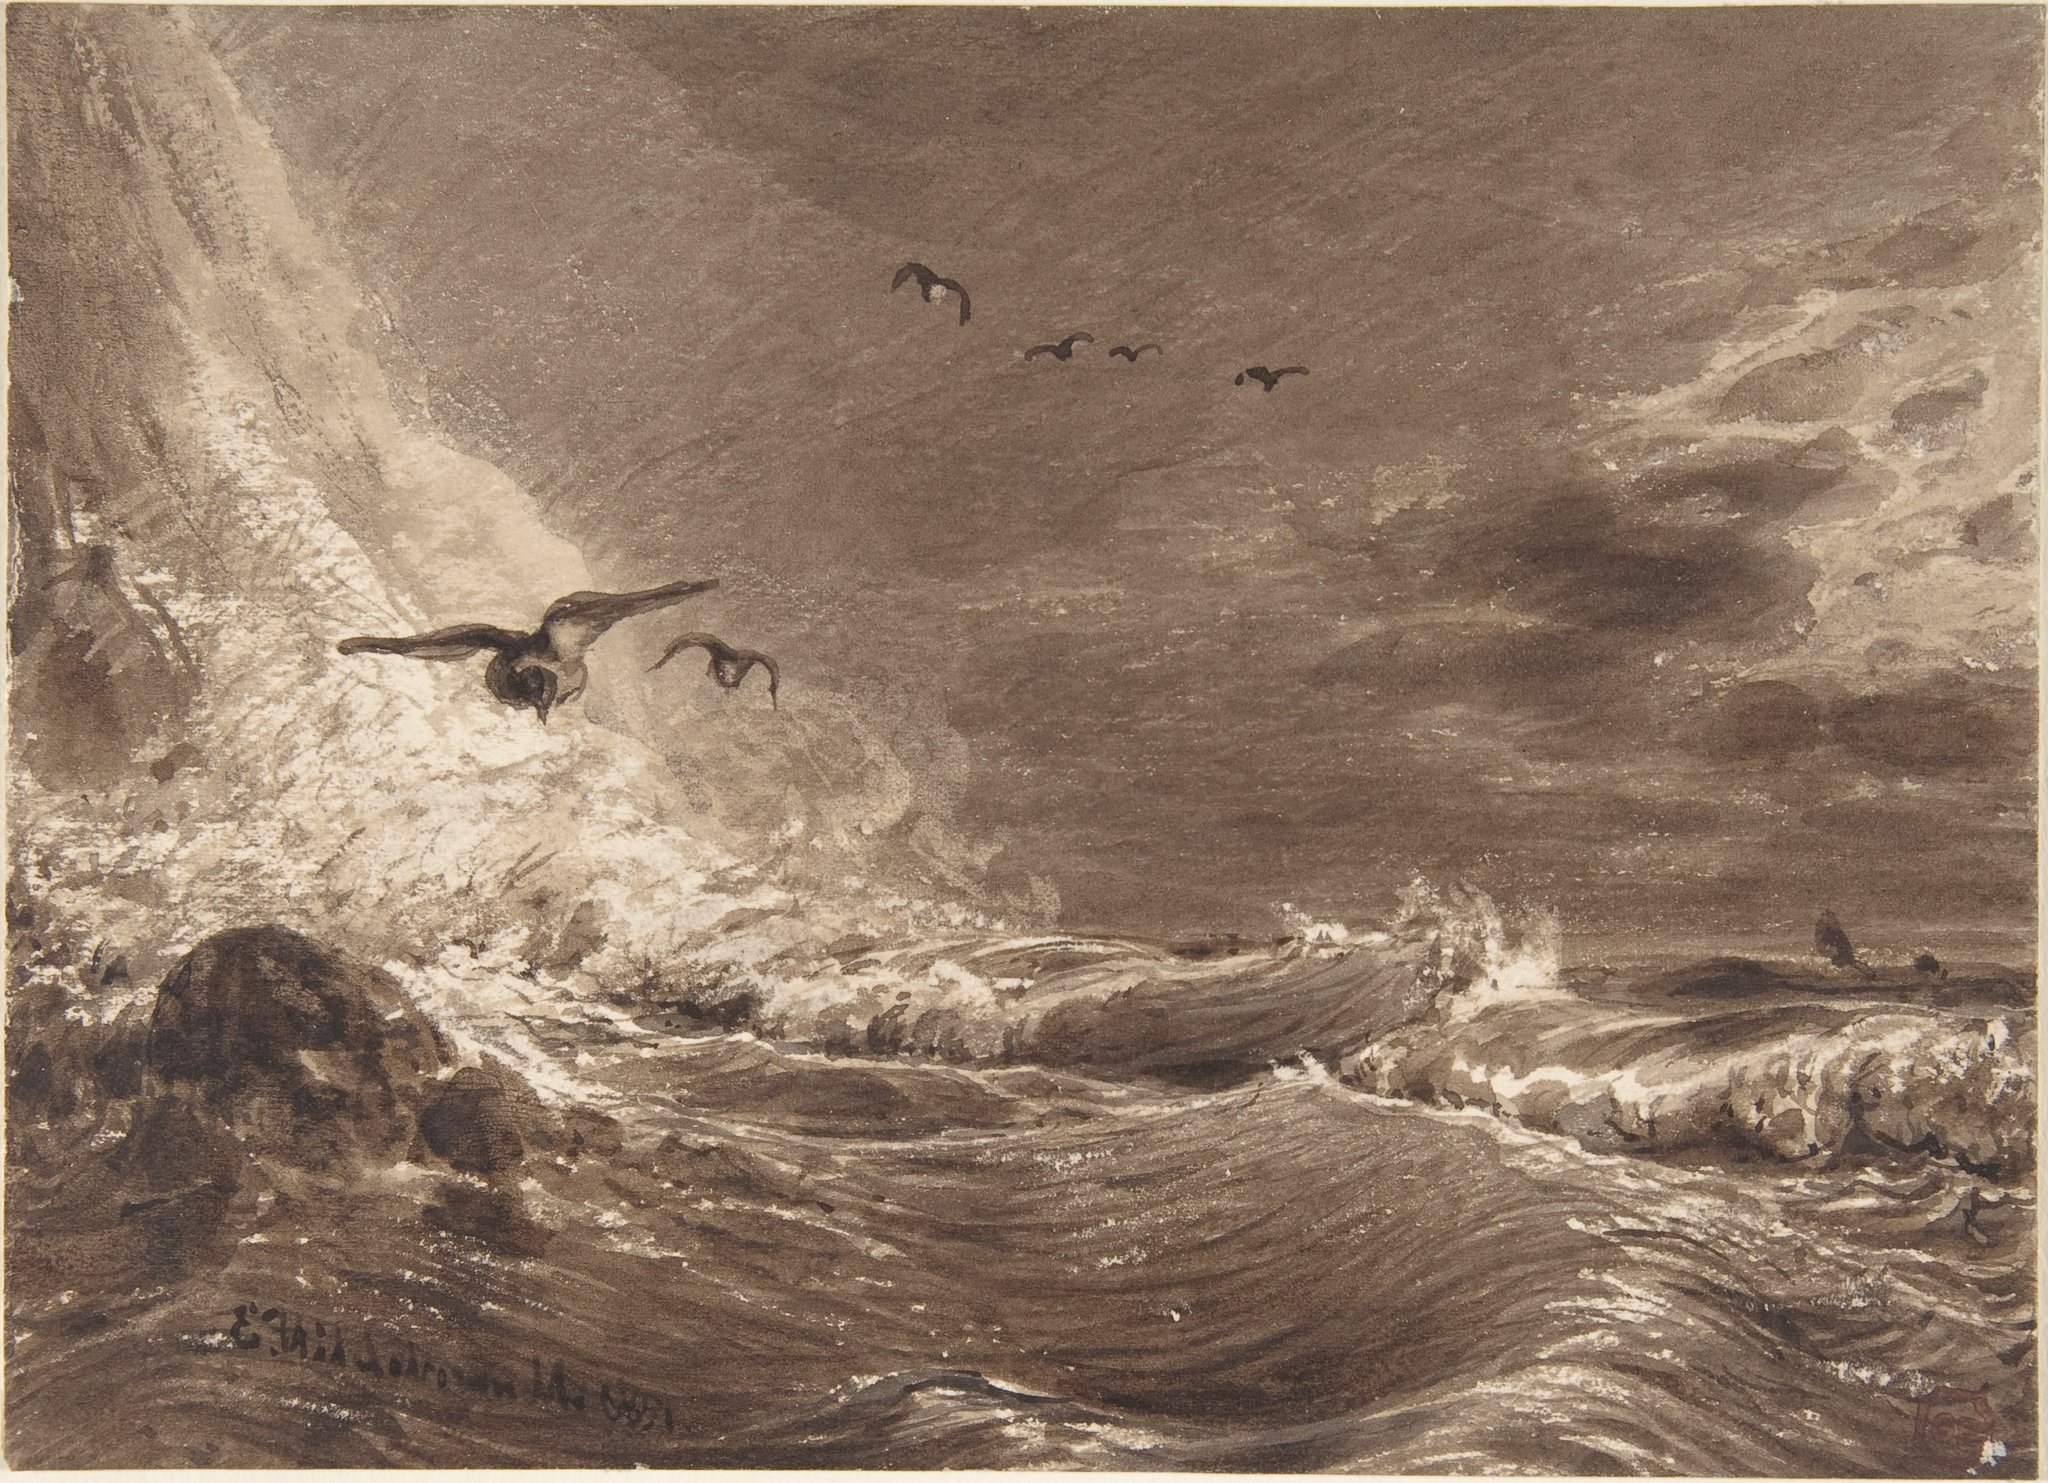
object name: drawing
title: Stormy Sea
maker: eduard hildebrandt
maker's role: artist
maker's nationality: german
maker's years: 1818-1869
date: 1851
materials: board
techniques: brush, wash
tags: birds,seascapes,storms